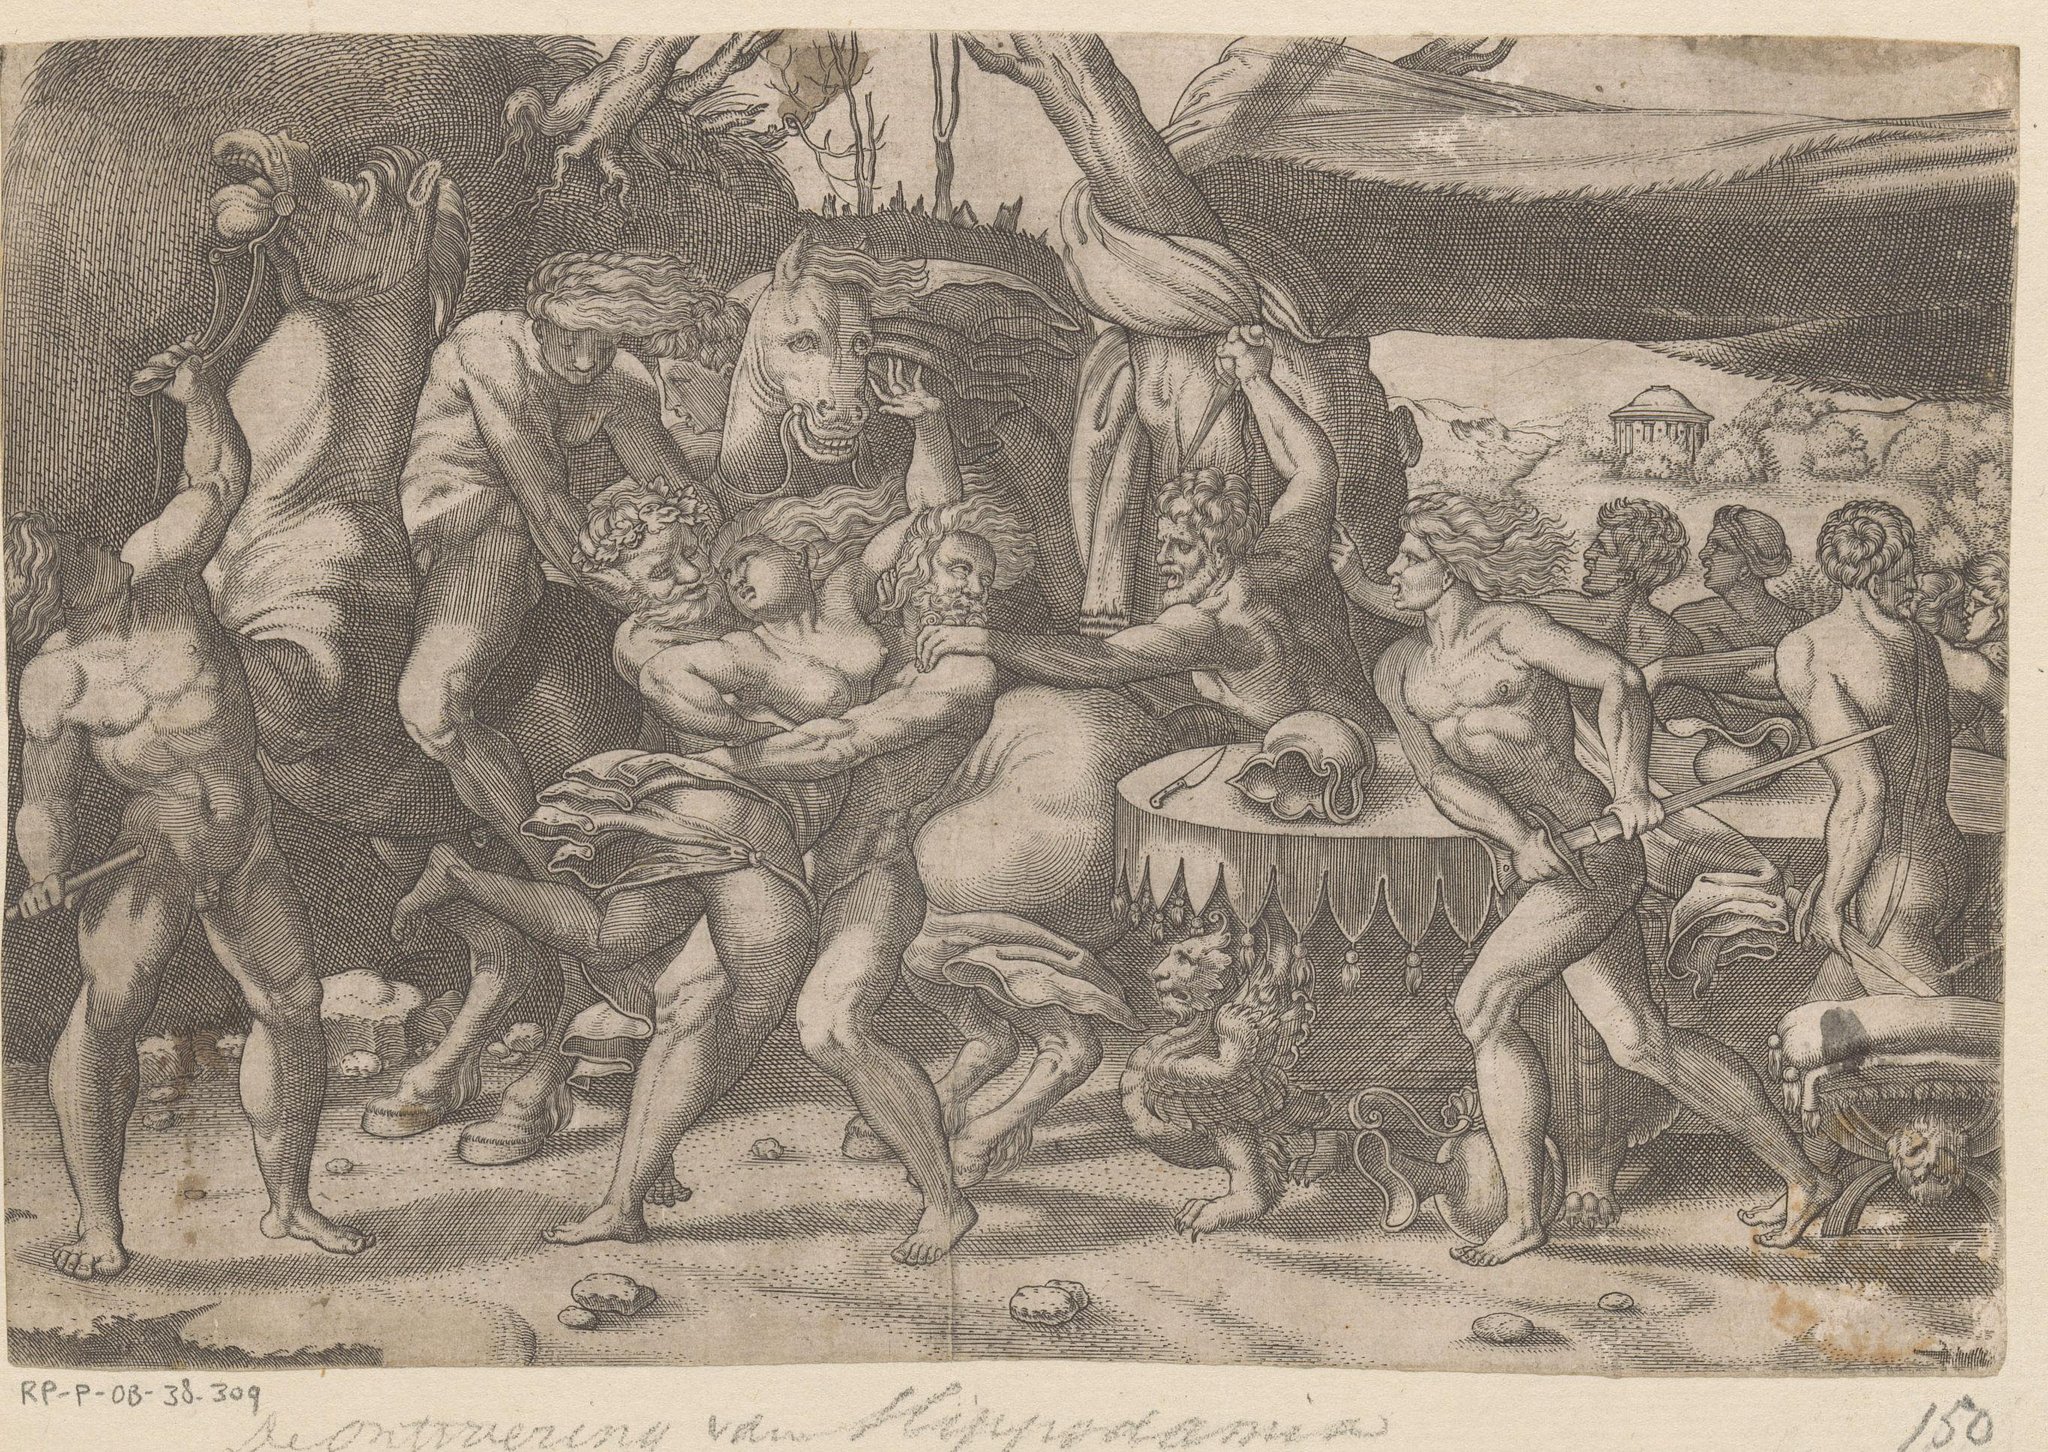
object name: print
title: Roof van een vrouw door man en sater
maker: Anonymous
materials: paper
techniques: engraving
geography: italy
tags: celebration meal, feast, banquet, man abducting woman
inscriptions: collector's mark: Lugt 240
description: In het midden wordt een vrouw geroofd door een man en een sater. Rechts verscheidene figuren rondom een tafel. Op de voorgrond heeft een man zijn zwaard getrokken, en achter de tafel zwaait een man met een dolk. Links twee paarden.